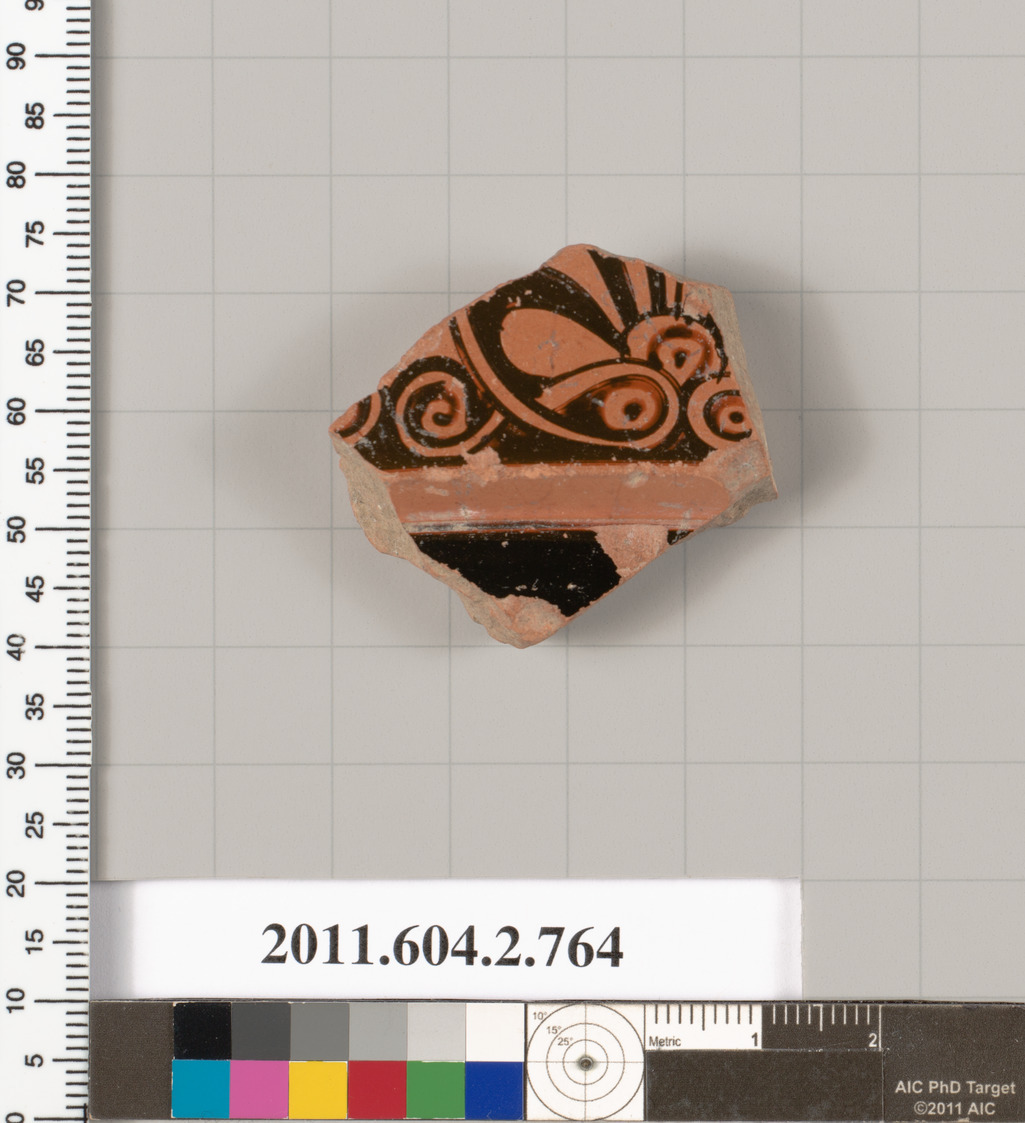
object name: calyx krater fragment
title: Terracotta fragment of a calyx-krater (bowl for mixing wine and water)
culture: greek, attic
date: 500-476 BCE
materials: terracotta